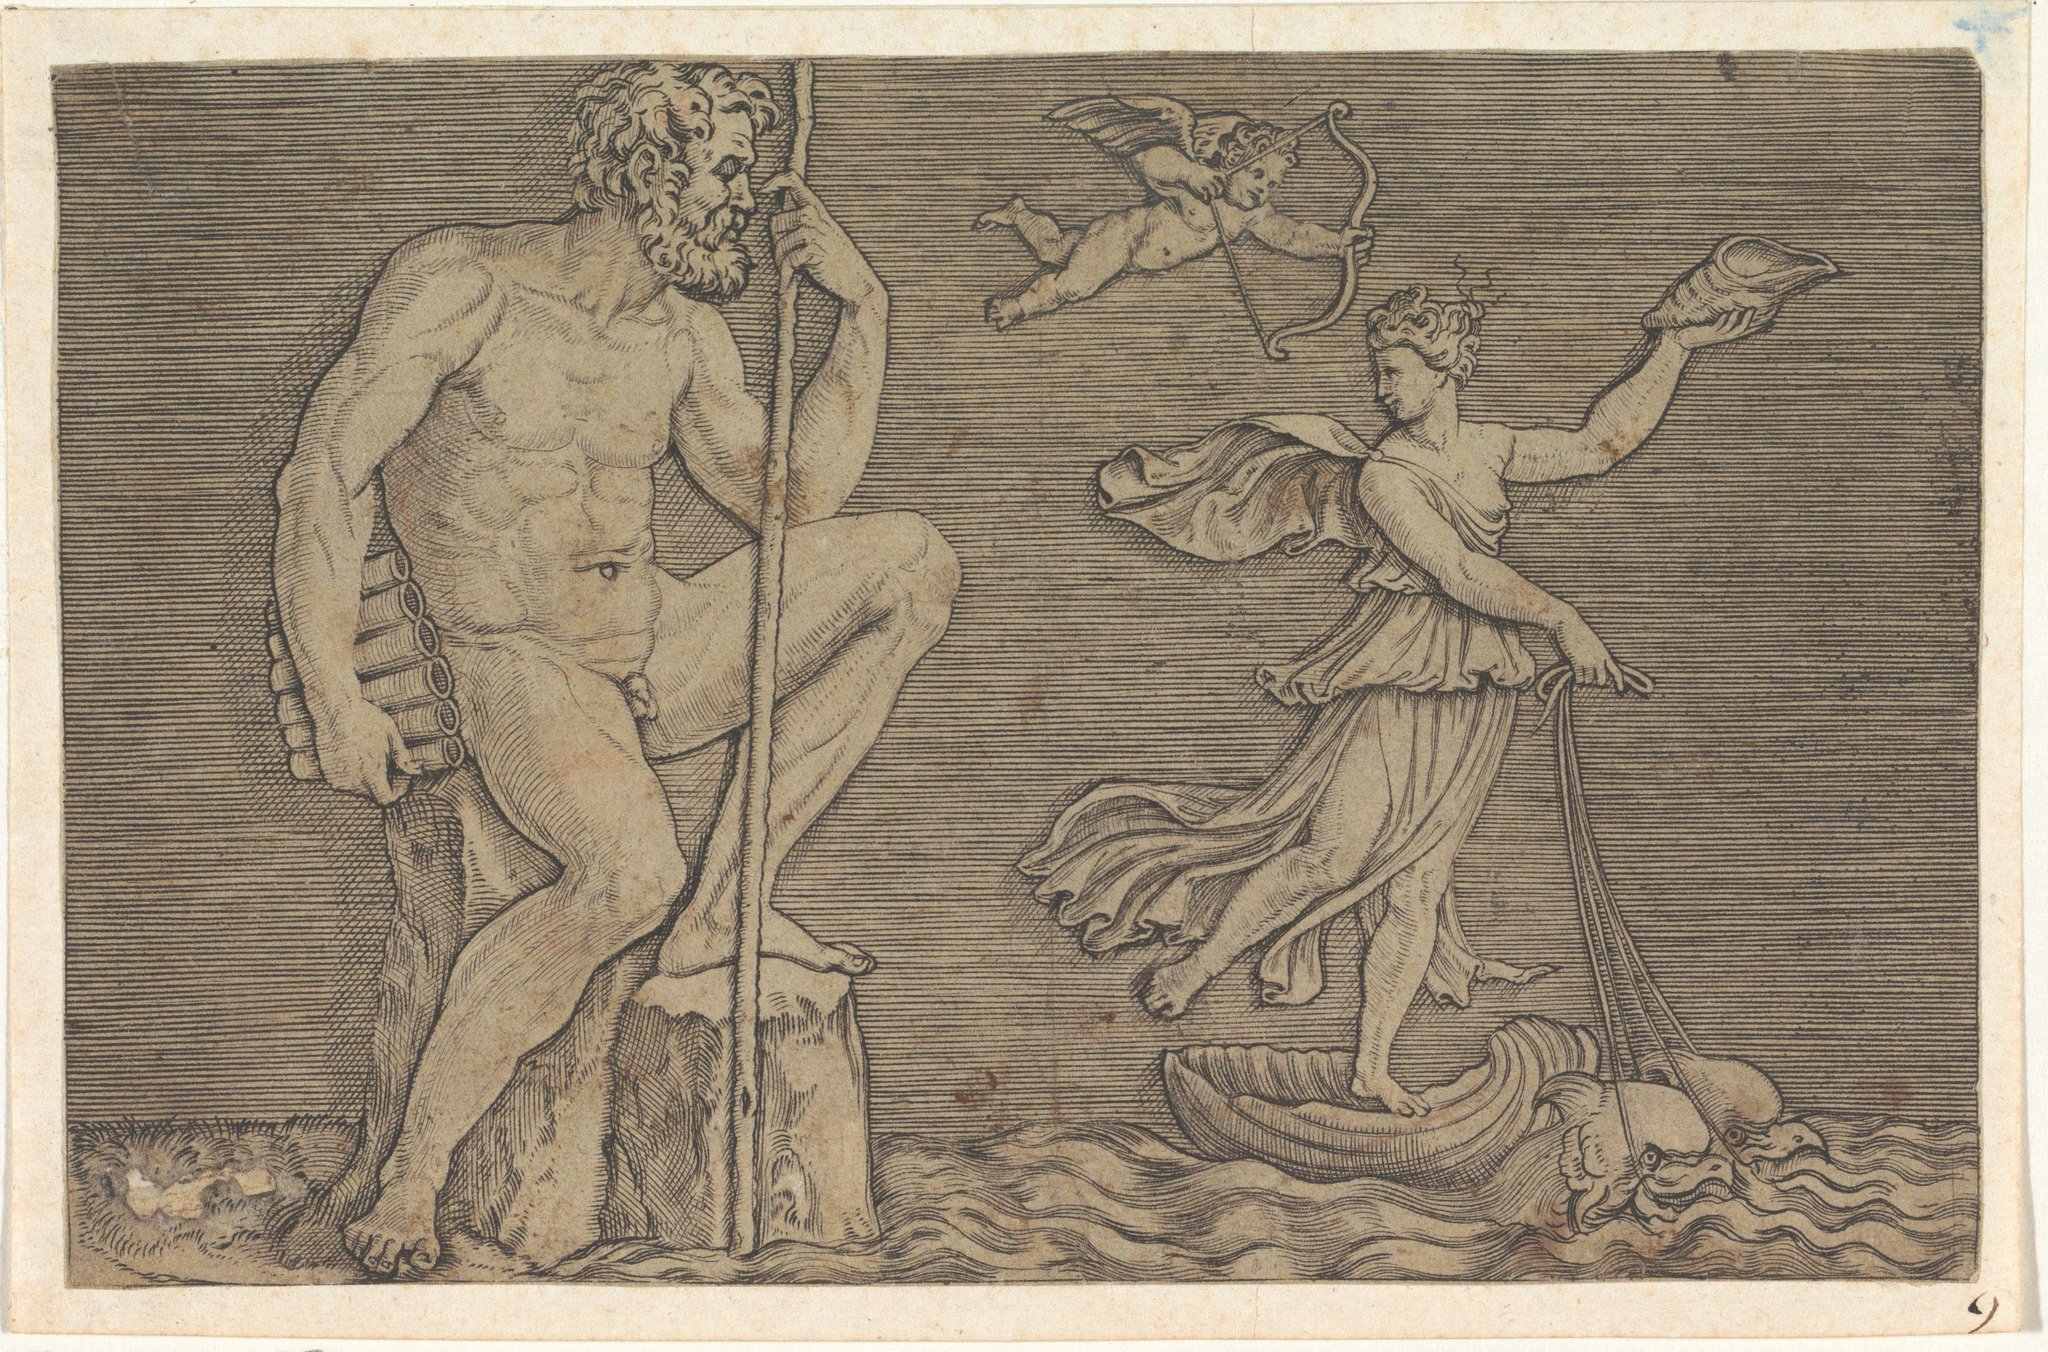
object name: print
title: Antieke reliëfs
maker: marco dente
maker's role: print maker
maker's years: 1486-1527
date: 1498-1532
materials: paper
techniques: engraving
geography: italy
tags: triumph of galatea, polyphemus playing the syrinx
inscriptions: number: ‘9’, collector's mark: Lugt 10, collector's mark: ‘Hinloopen’, collector's mark: Lugt 11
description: Galatea, rijdend op een door dolfijnen getrokken schelp, ontsnapt aan de cycloop Polyphemus. Polyphemus zit op een rots met een stok en een panfluit in zijn handen. Amor vliegt boven Galatea.